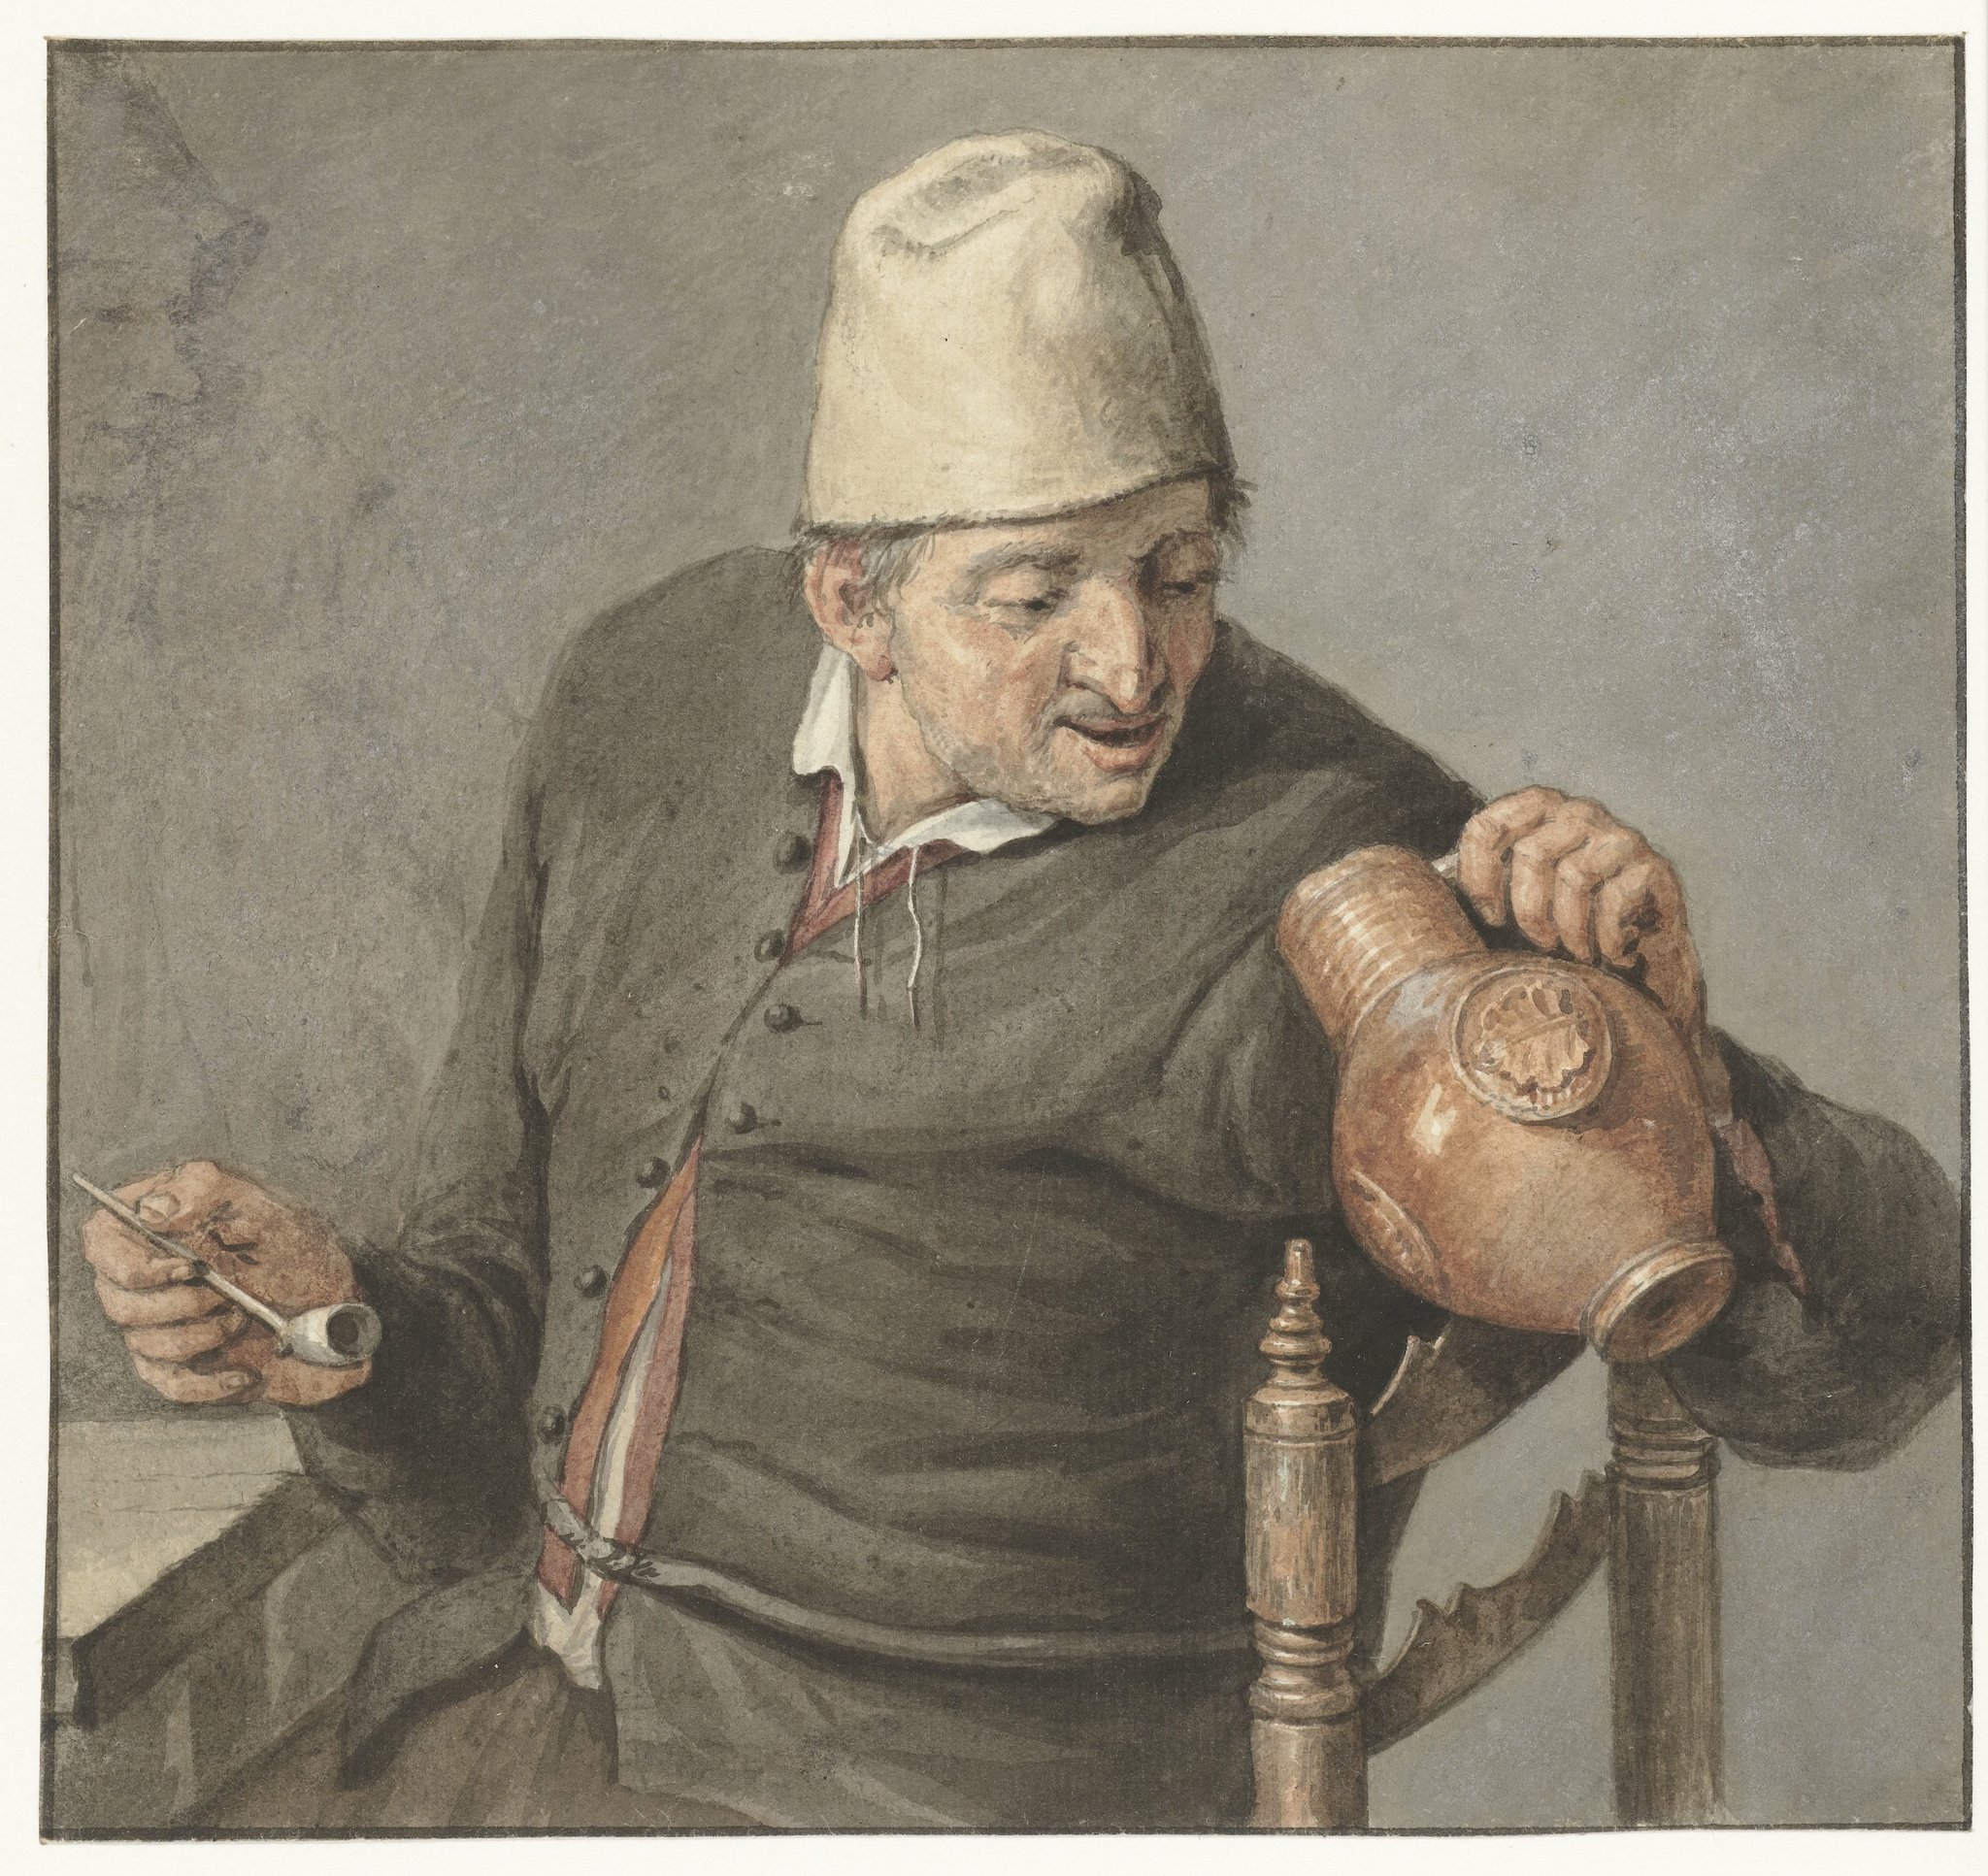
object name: drawing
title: Roker, kijkend in een kruik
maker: Anonymous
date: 1670-1750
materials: paper, watercolor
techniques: brush